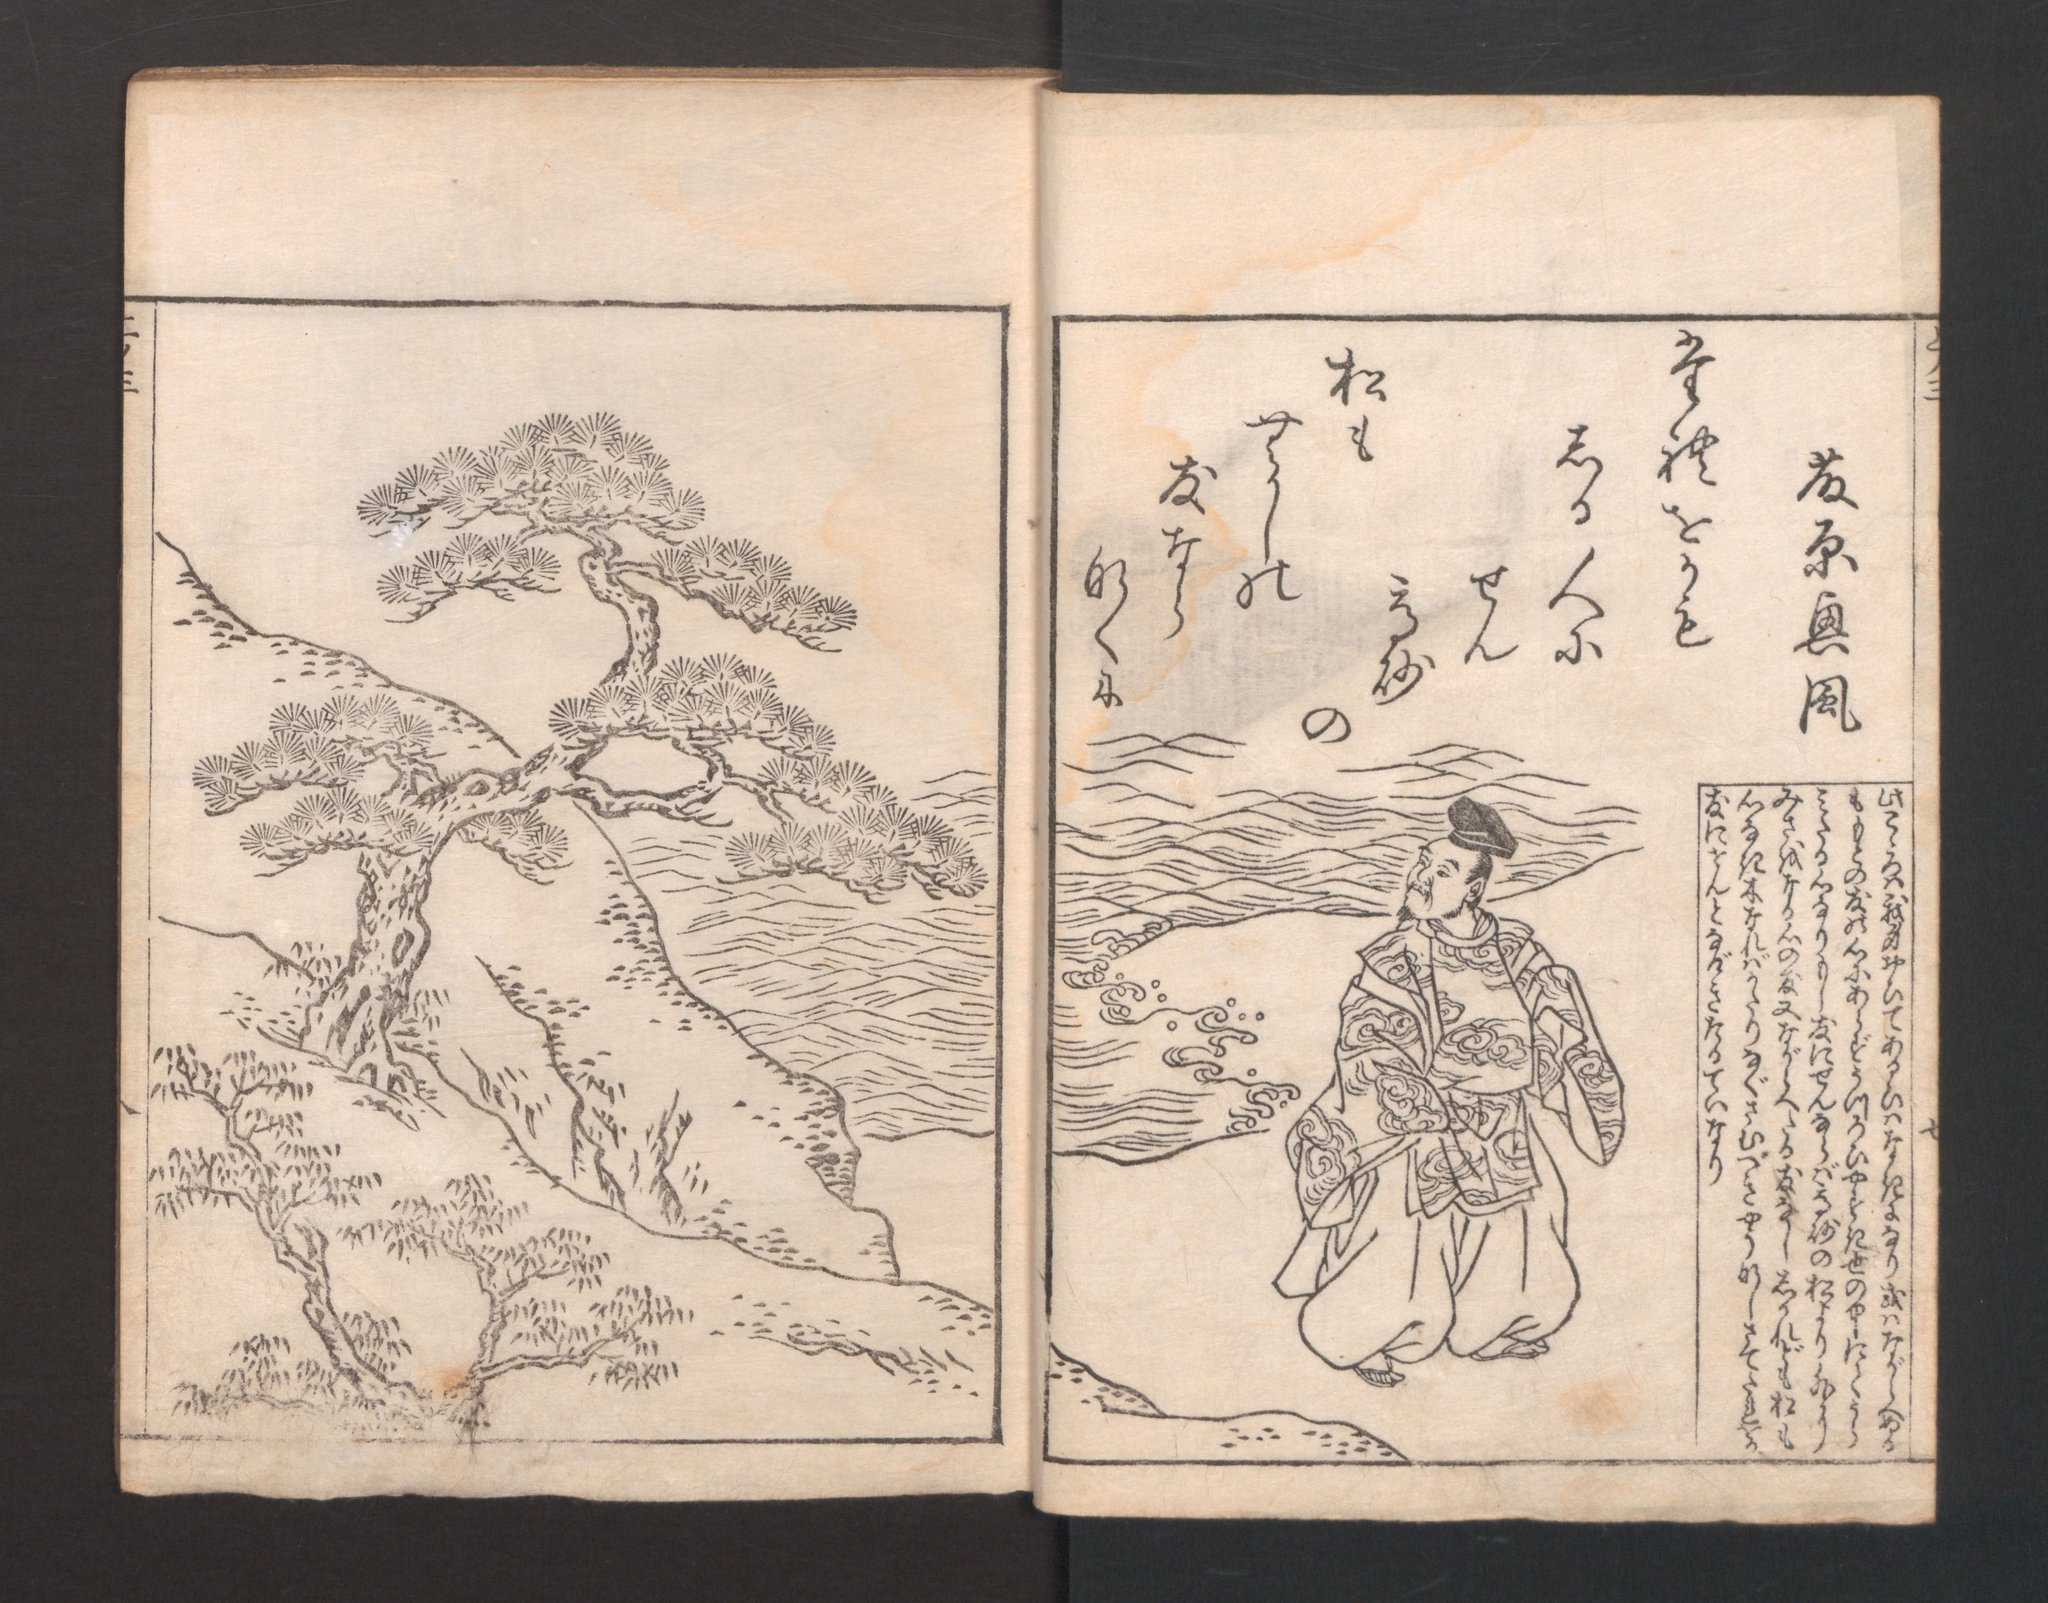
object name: illustrated book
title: Picture Book: Ogura Hill (Ehon Ogurayama) 絵本小倉山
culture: japanese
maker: nishikawa sukenobu 西川祐信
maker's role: artist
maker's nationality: japanese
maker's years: 1671-1750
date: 1749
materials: ink, paper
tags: men,hills